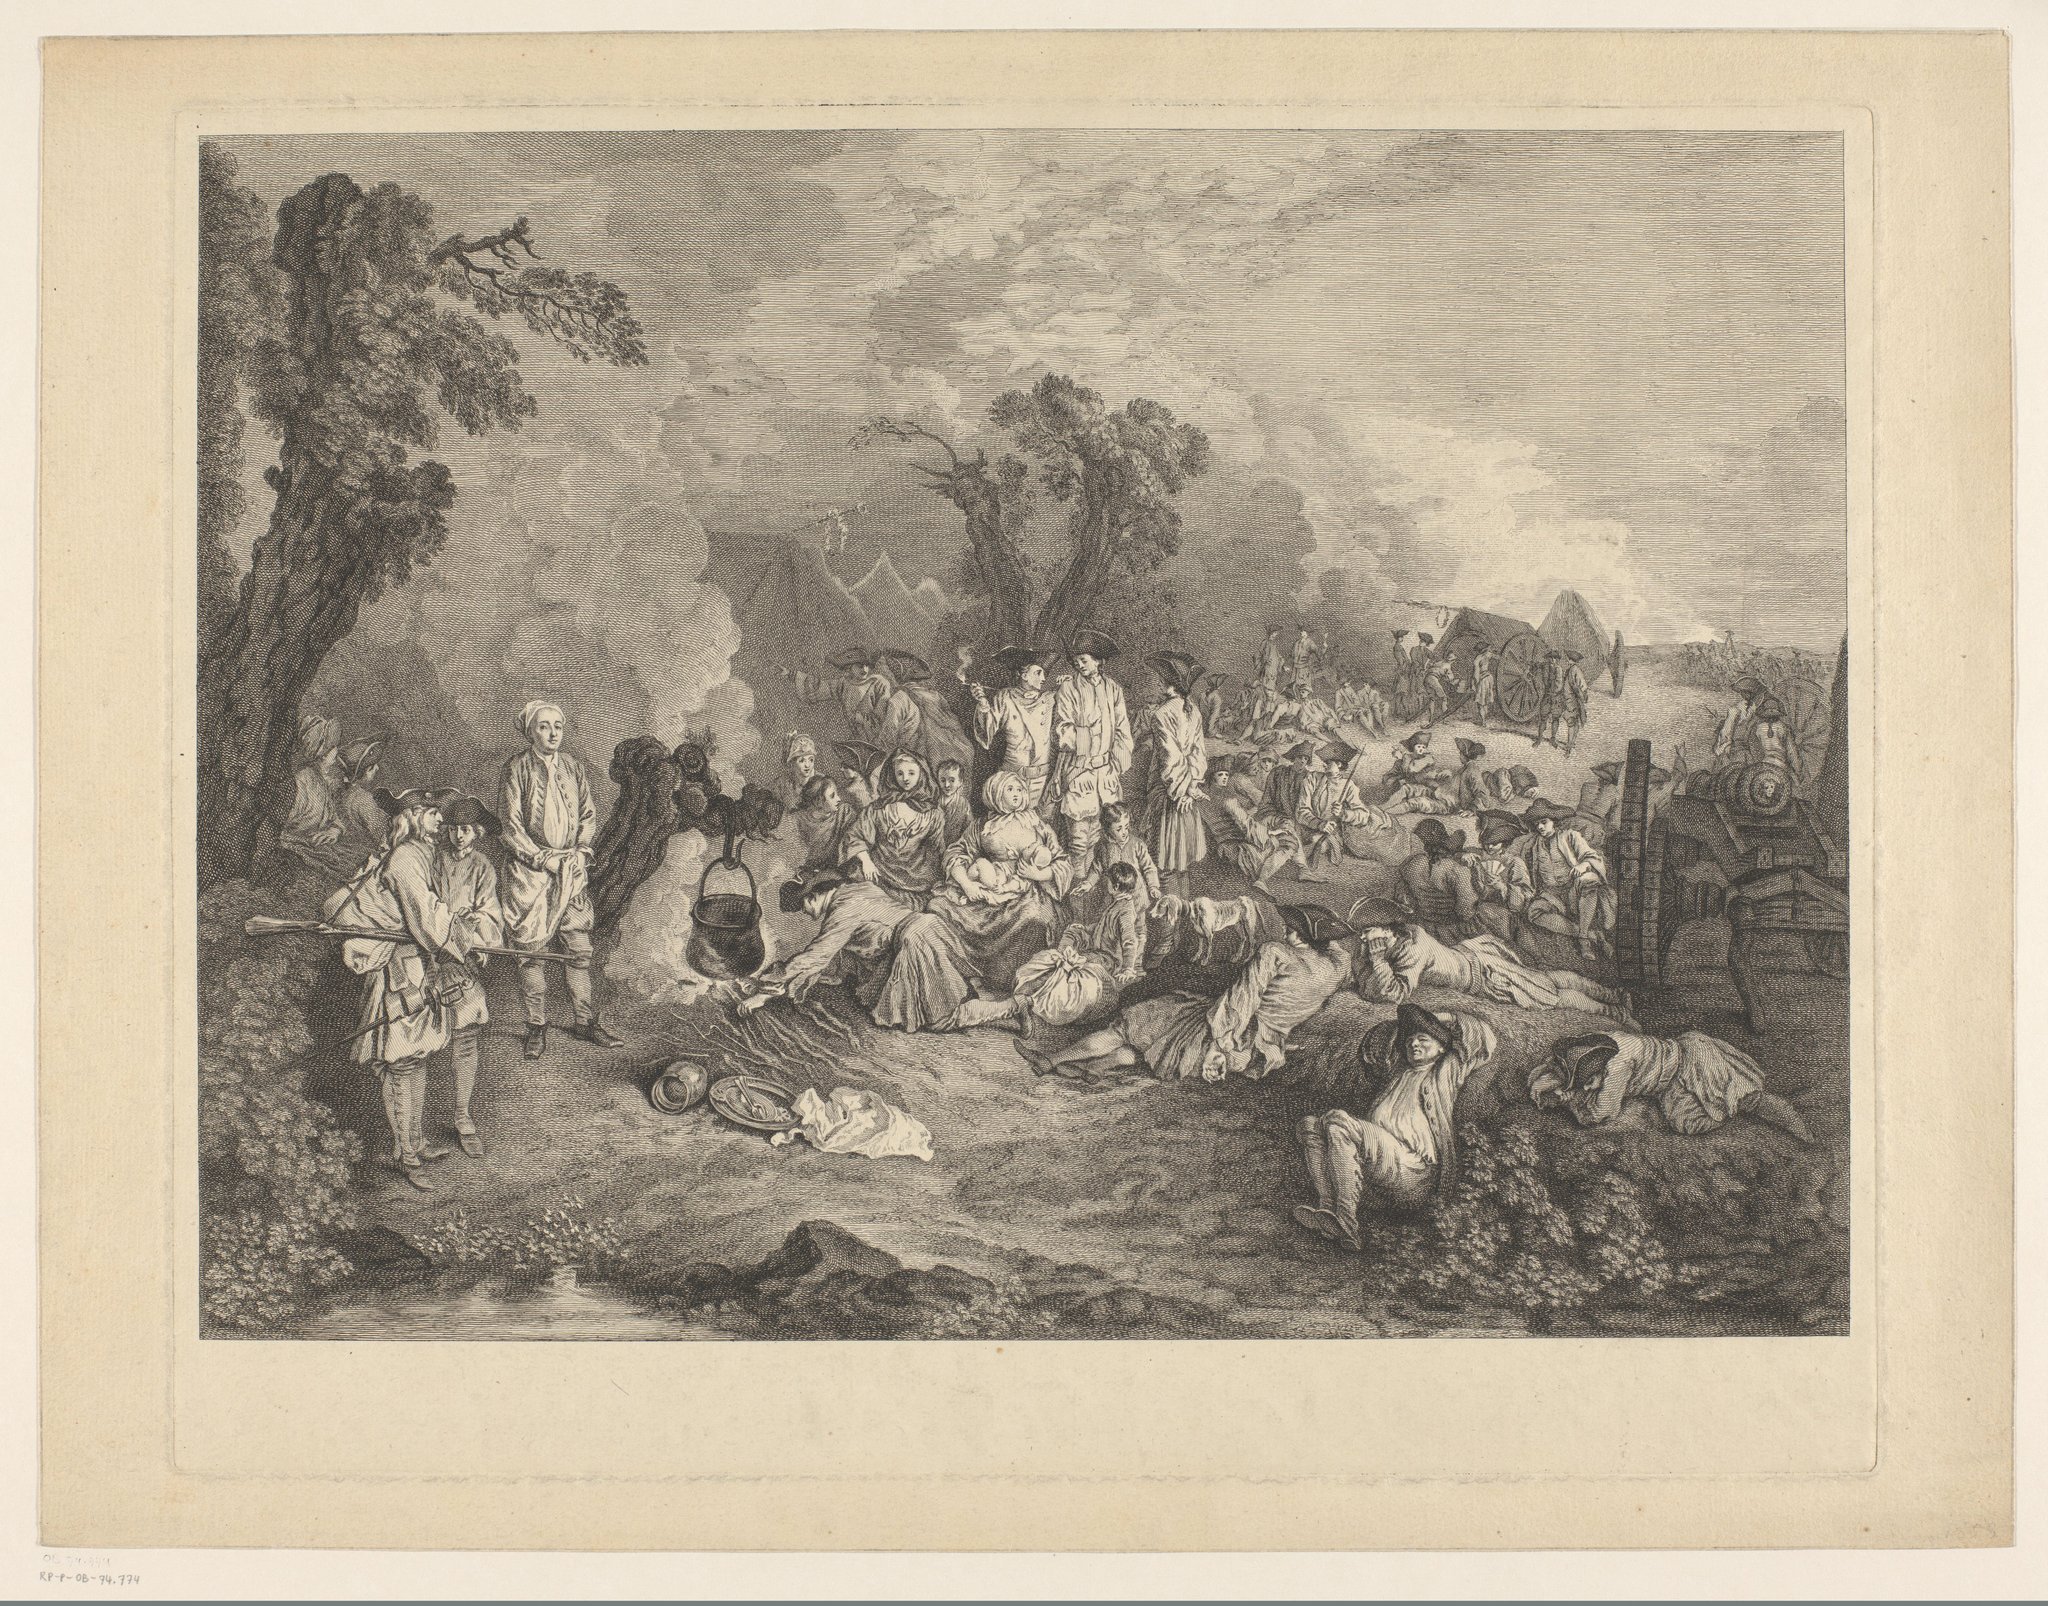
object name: print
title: Camp Volant / Expeditum Agmen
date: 1727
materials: paper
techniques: engraving, etching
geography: france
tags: (military) camp with tents, women camp-followers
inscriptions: collector's mark: Lugt 2228